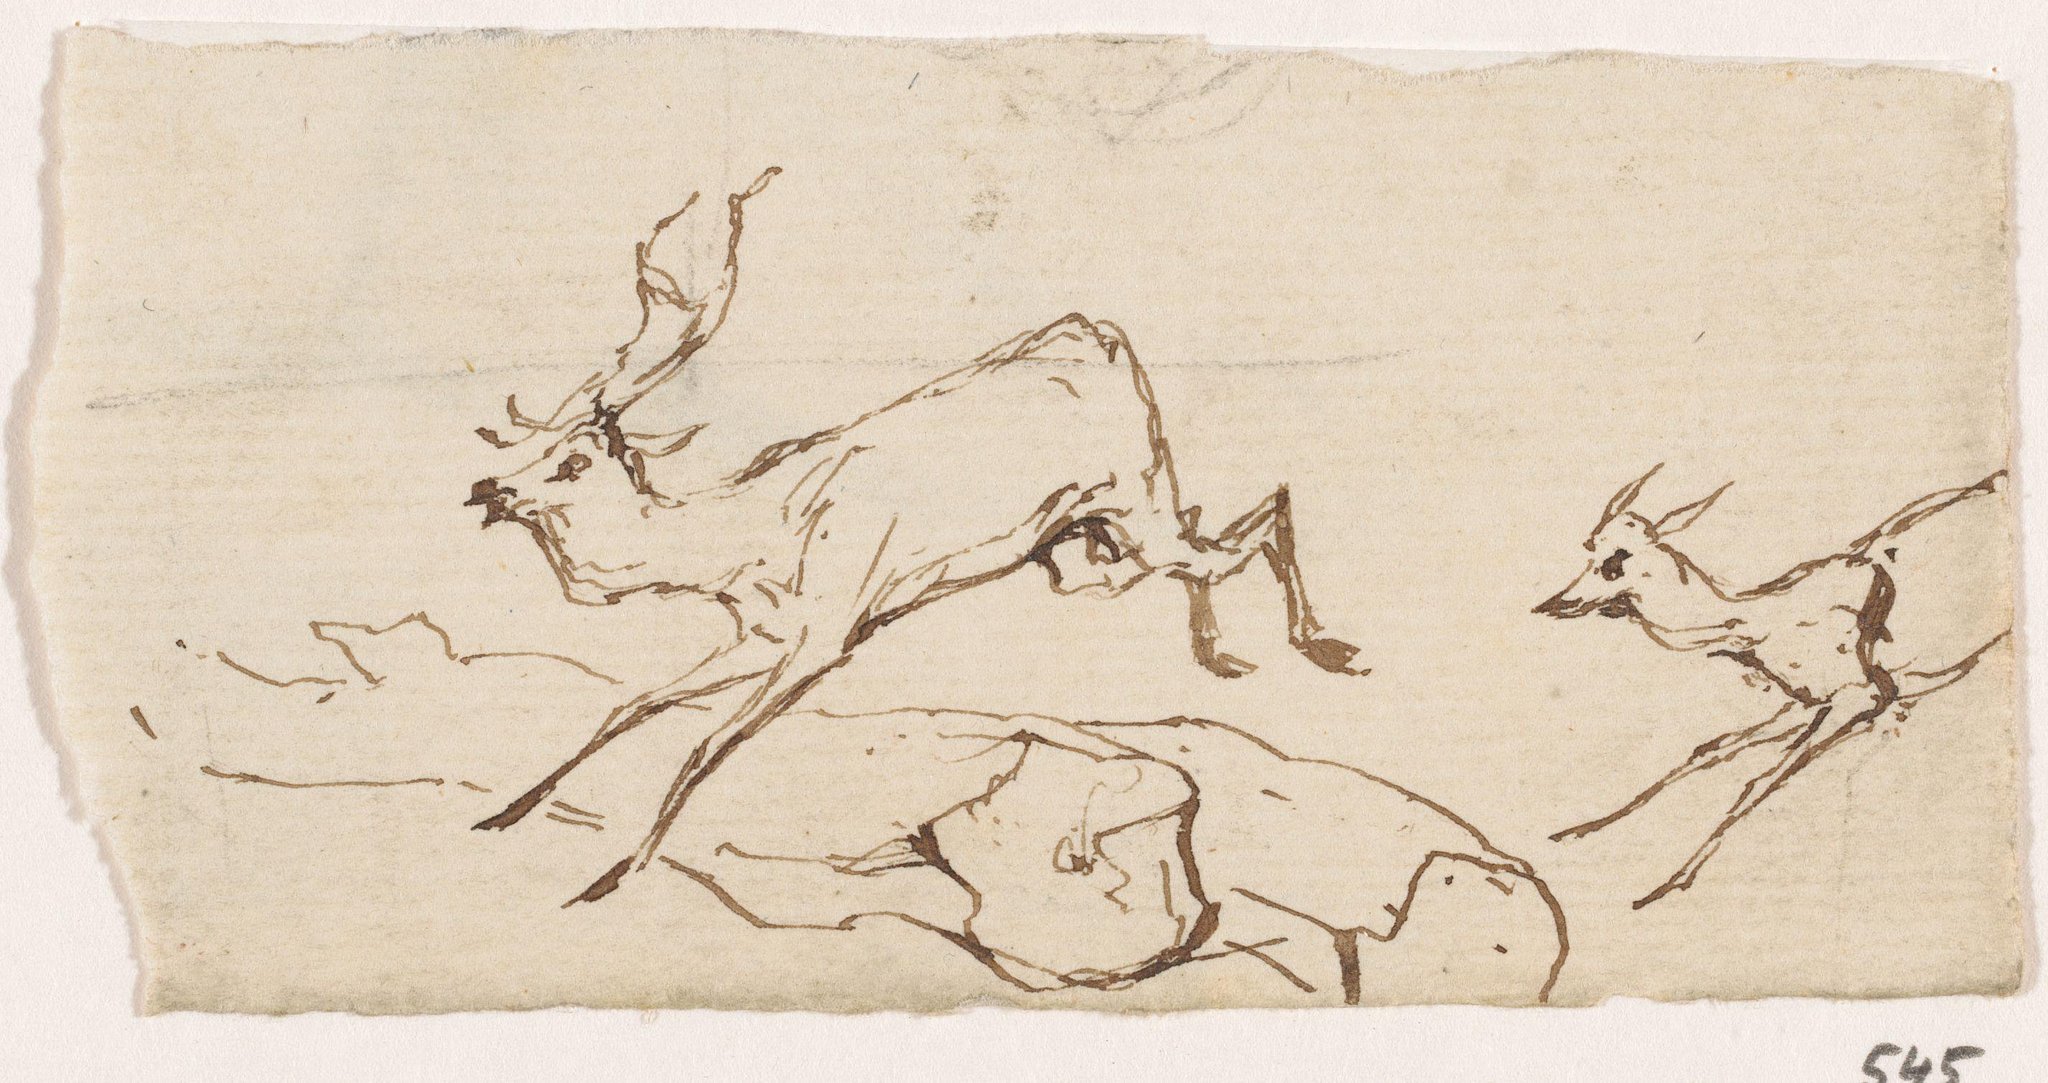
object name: drawing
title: Herten springend over een boomstam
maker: johannes tavenraat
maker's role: draughtsman, painter, print maker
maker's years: 1809-1881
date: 1840-1880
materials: ink, paper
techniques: pen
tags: hoofed animals: deer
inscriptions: collector's mark: Lugt 2228